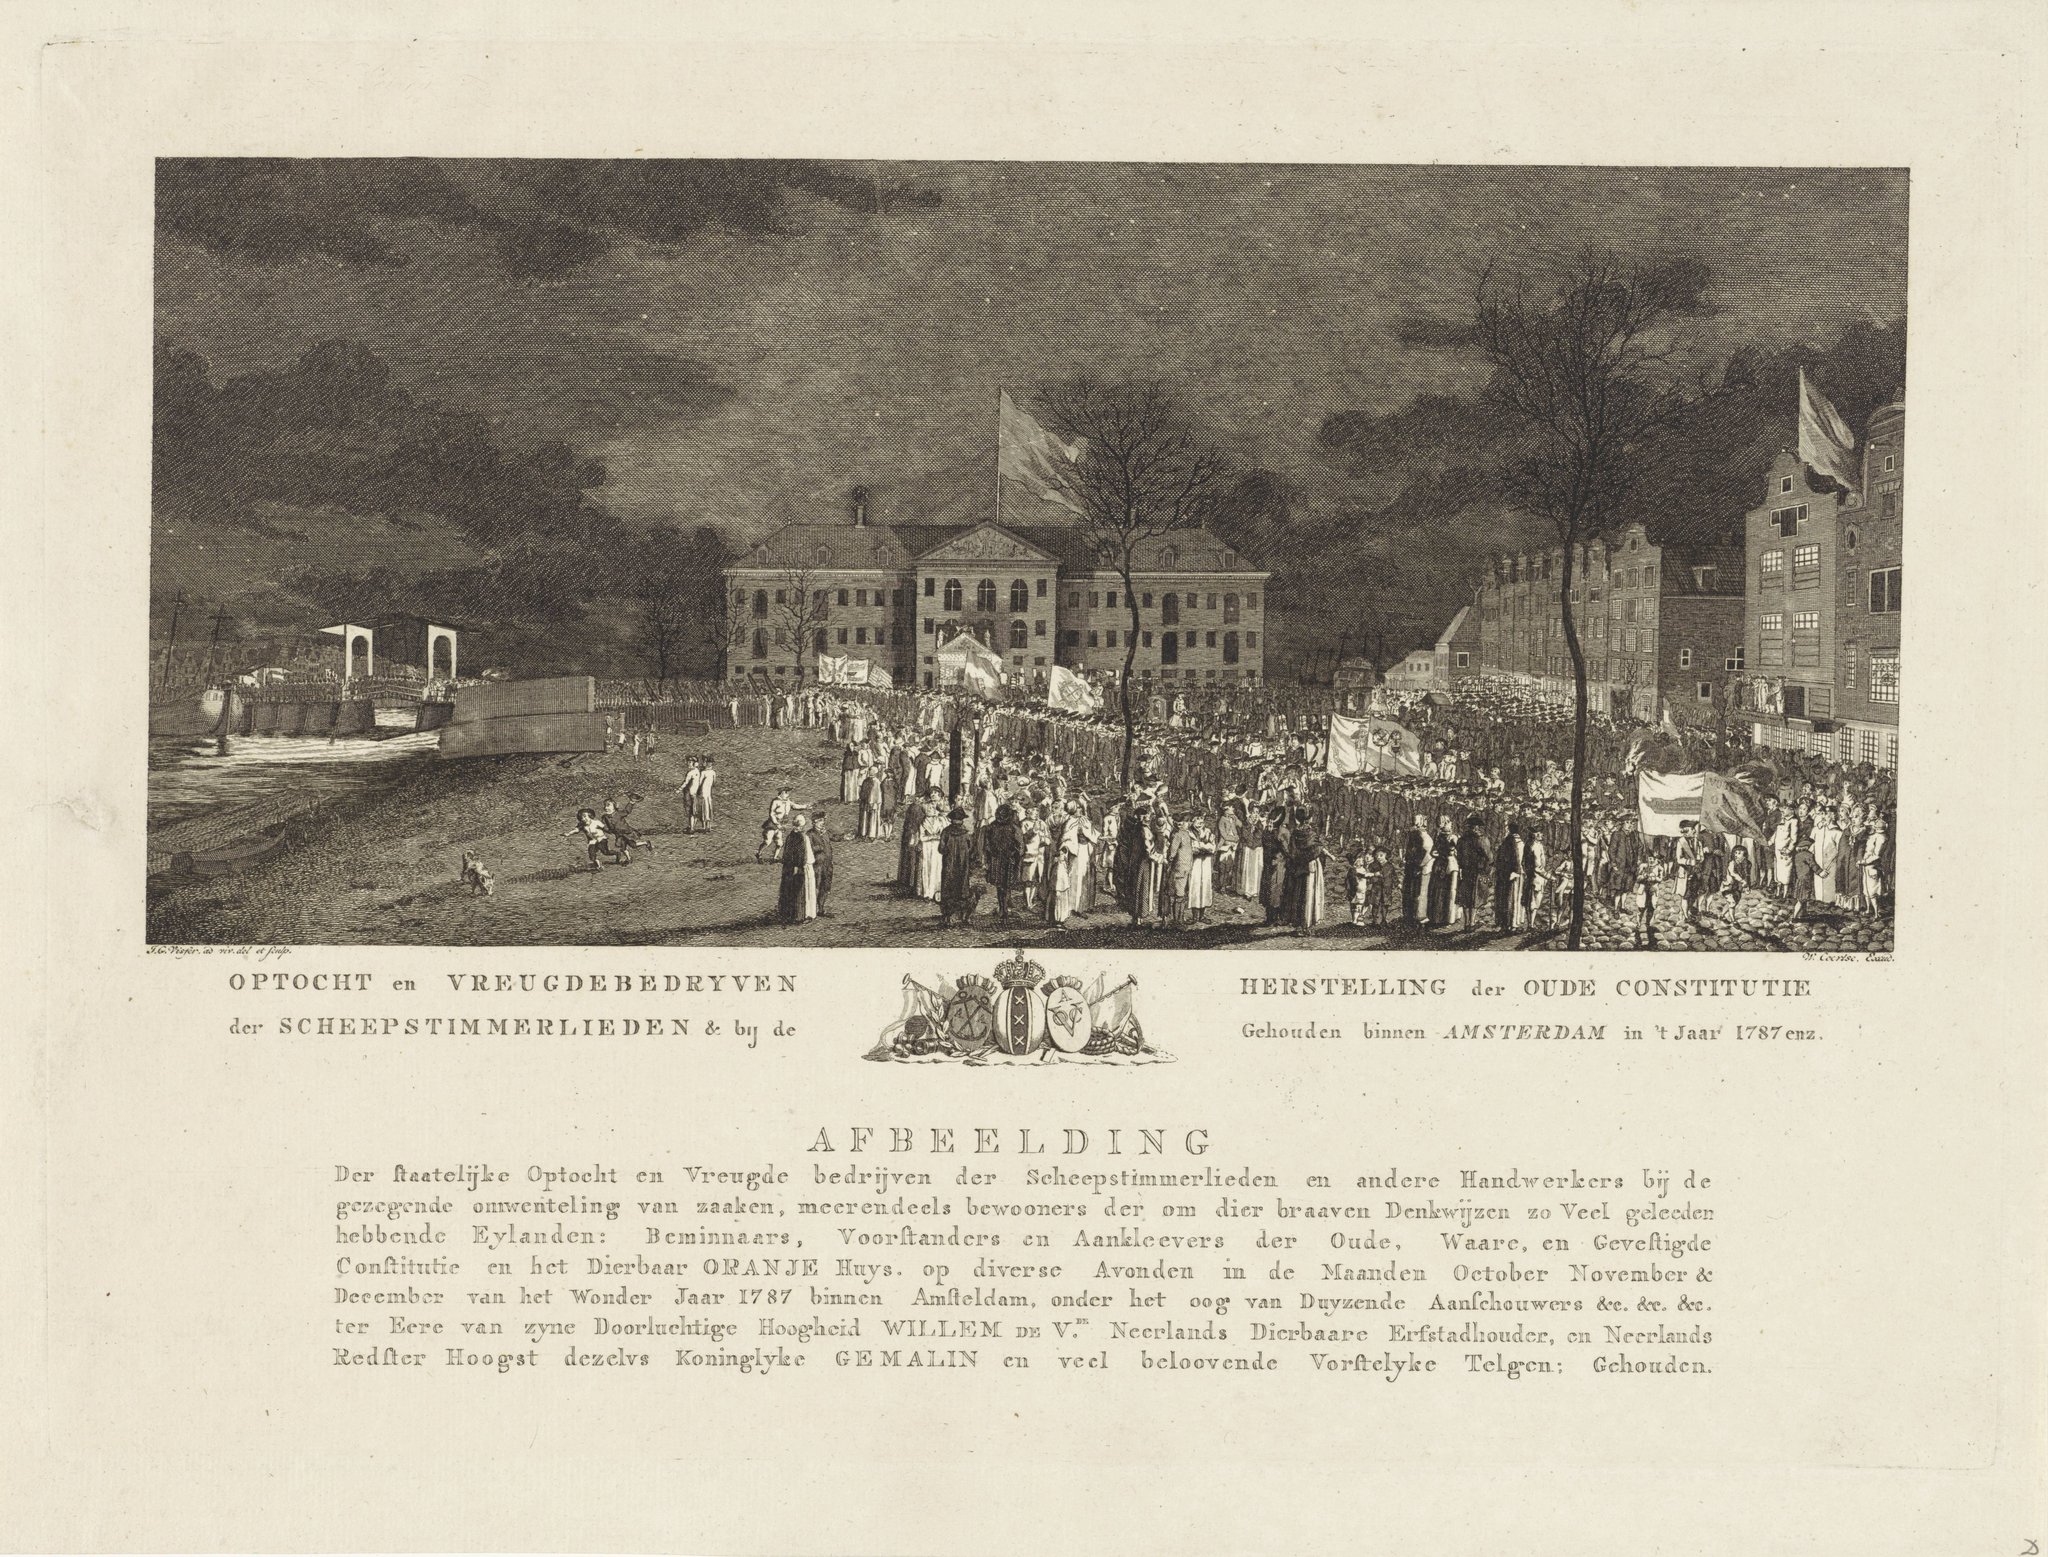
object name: print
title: Optocht en Vreugdebedryven der Scheepstimmerlieden & bij de Herstelling der Oude Constitutie Gehouden binnen Amsterdam in 't Jaar 1787 enz.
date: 1787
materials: paper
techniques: engraving, etching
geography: amsterdam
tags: william v (prince of orange), public festivities at other royal events, not meant or mentioned above (+ parade, pageant, cavalcade ~ festive activities)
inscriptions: collector's mark: Lugt 2228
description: Optocht van de Oranjegezinde Amsterdamse scheepstimmerlieden op het Kattenburgerplein te Amsterdam, ter viering van het herstel van stadhouder Willem V. Gehouden op verschillende avonden in de maanden oktober, november en december 1787. Hier waarschijnlijk de optocht van 20 december 1787. Onder de voorstelling het wapen van de Admiraliteit van Amsterdam.